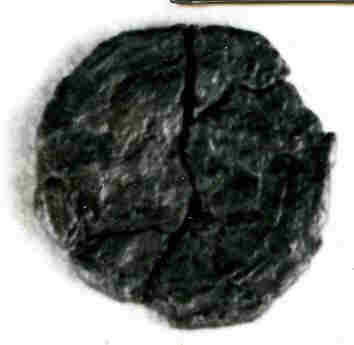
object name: coin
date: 701-900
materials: copper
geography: iran